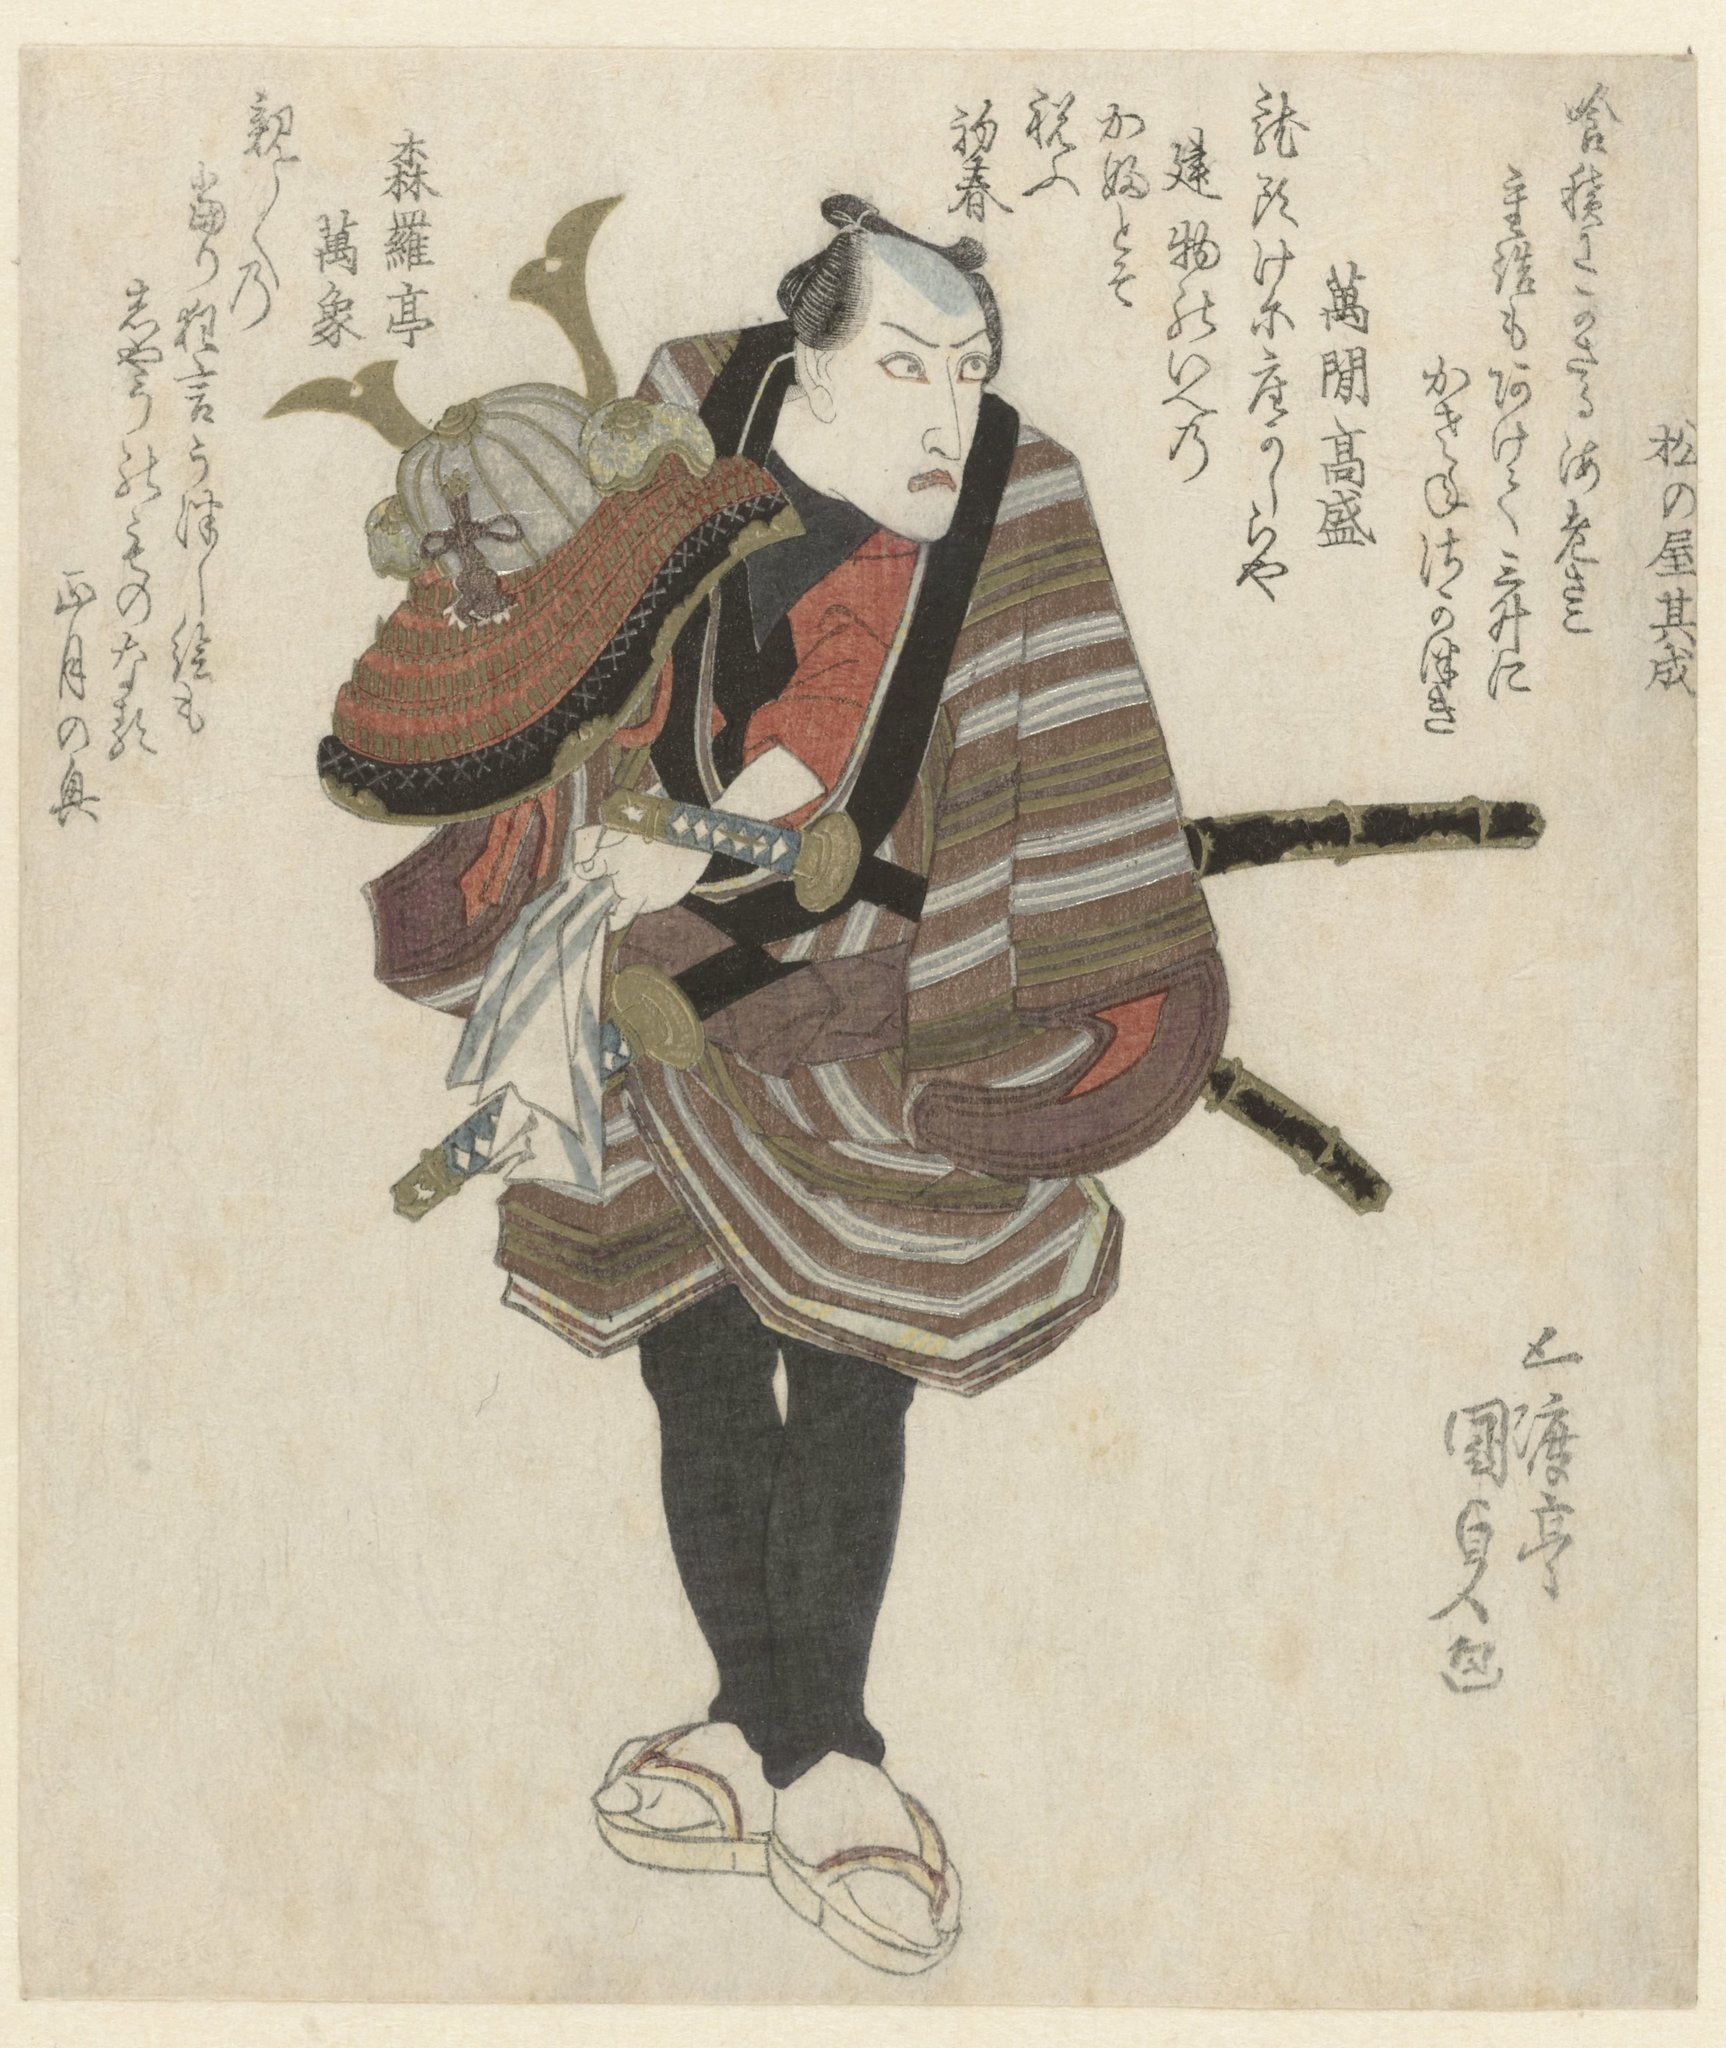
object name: surimono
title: A Samurai Holding a Helmet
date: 1821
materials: paper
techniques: blind stamped, woodcut, polish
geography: japan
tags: standing figure, portrait of actor, actress, (military) equipment and supply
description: Een surimono is een luxe uitgevoerde prent waarop beeld met één of meerdere gedichten gecombineerd is. Bij het drukken van een surimono werd vaak gebruik gemaakt van dikker papier, blinddruk en metaal pigmenten, zoals koper- en zilverpoeder. De prenten werden vaak in opdracht van dichters gemaakt en als exclusief geschenk aan vrienden en relaties gegeven.